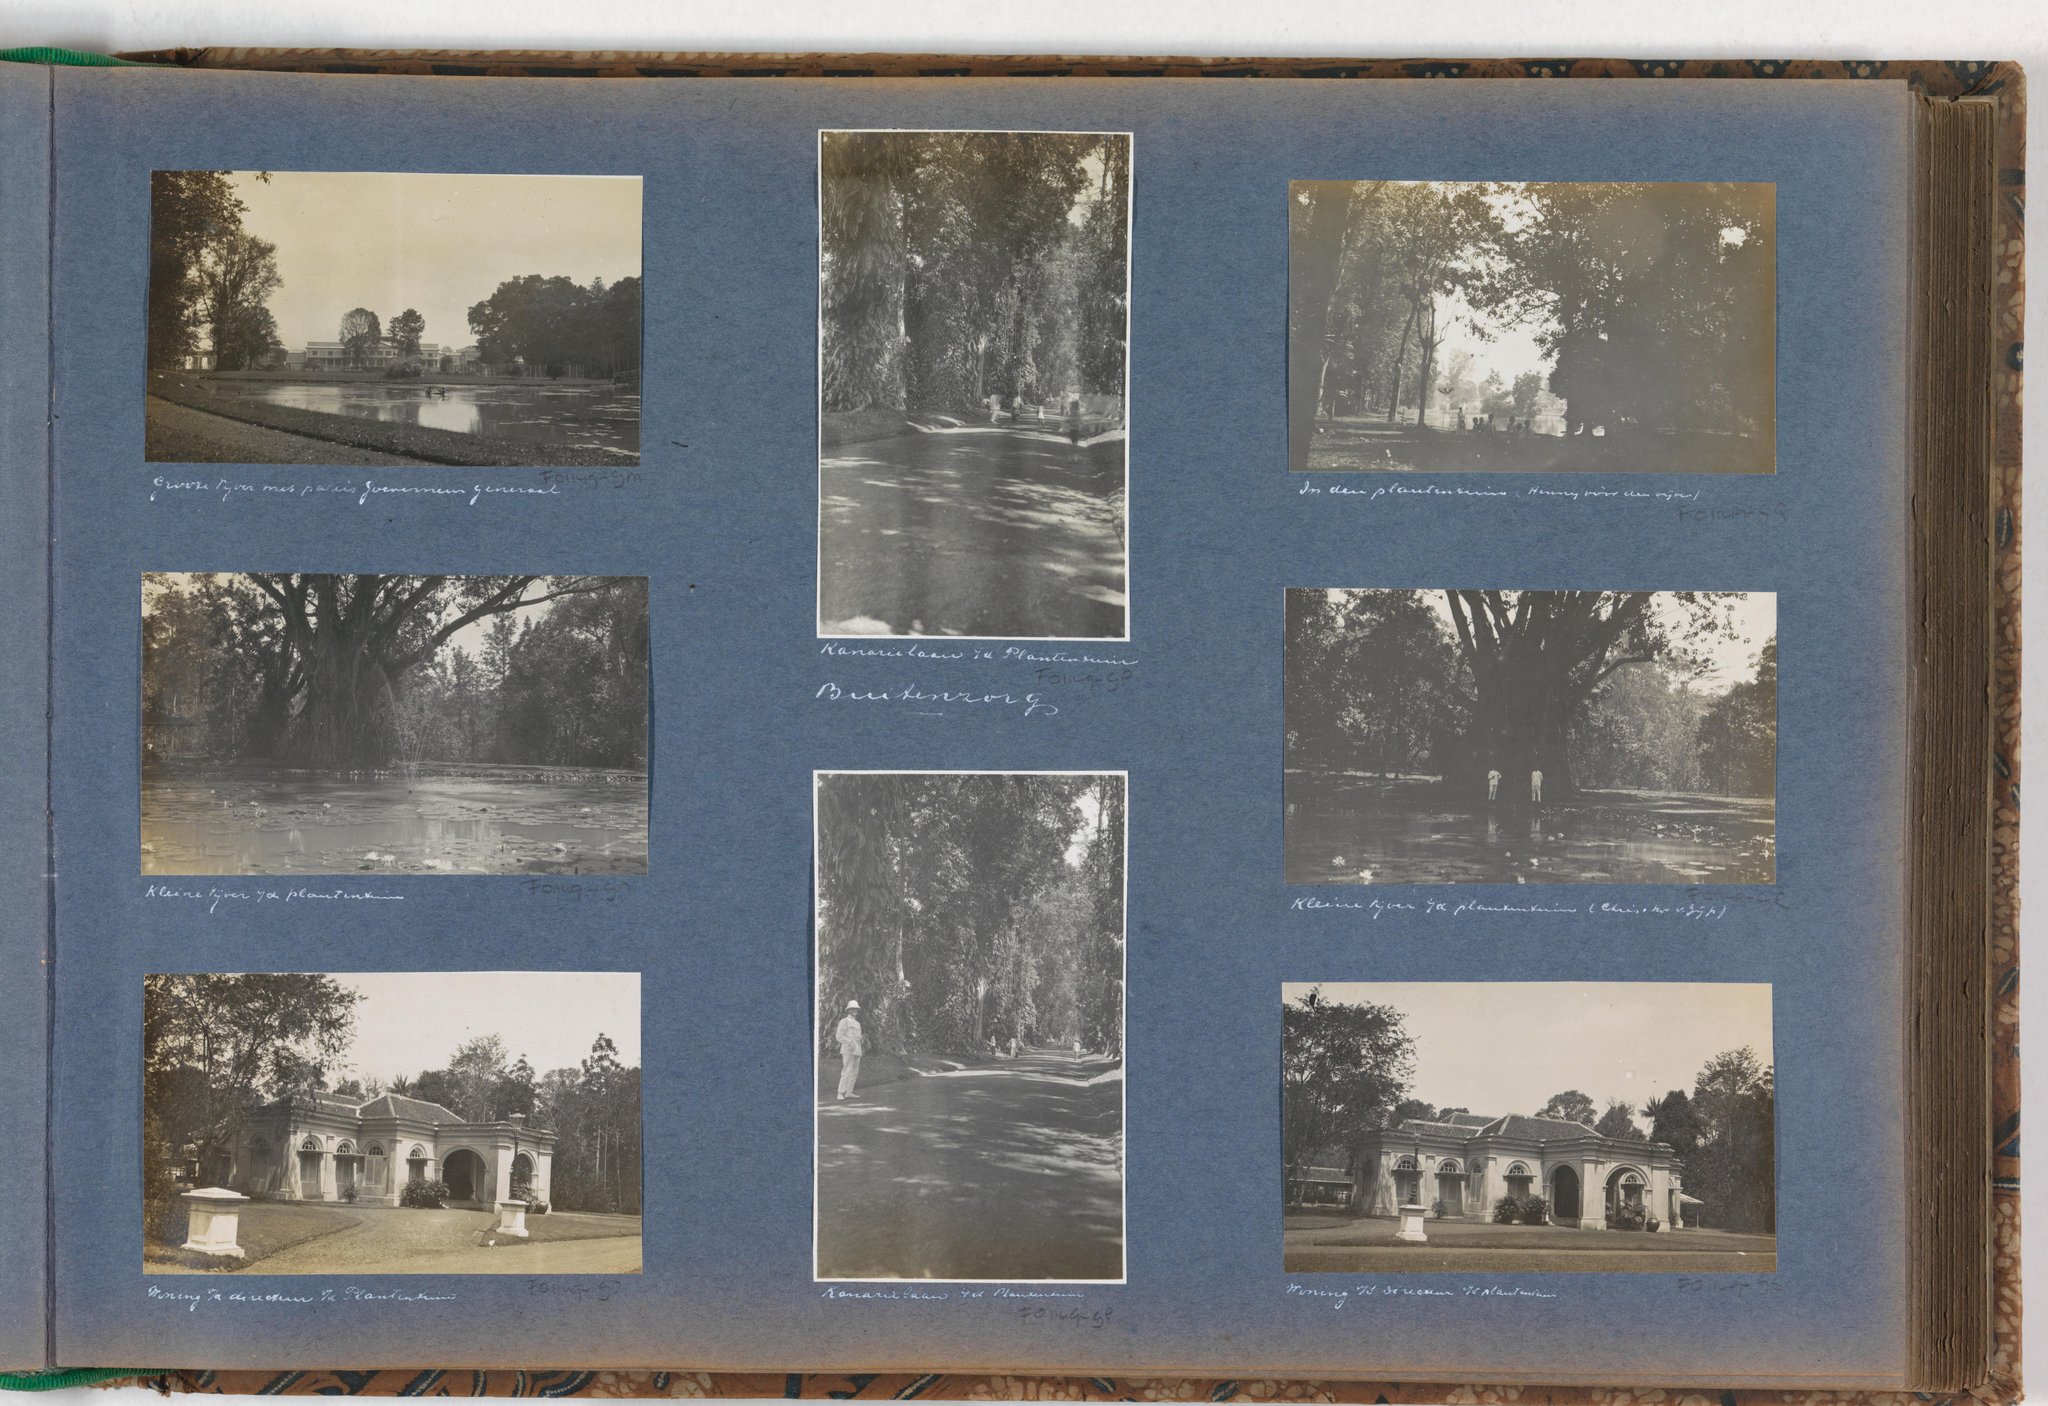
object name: photograph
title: Exterieur van het huis van de directeur in 's Lands Plantentuin te Buitenzorg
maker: Anonymous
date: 1900-1920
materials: paper, photographic support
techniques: gelatin silver print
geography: s lands plantentuin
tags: rural housing, e.g. country-house, villa, cottage, botanic garden, 'hortus botanicus'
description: Onderdeel van reisalbum met foto's van bedrijvigheid en bezienswaardigheden op Sumatra en Java en van de reis naar en van Nederlands-Indië.